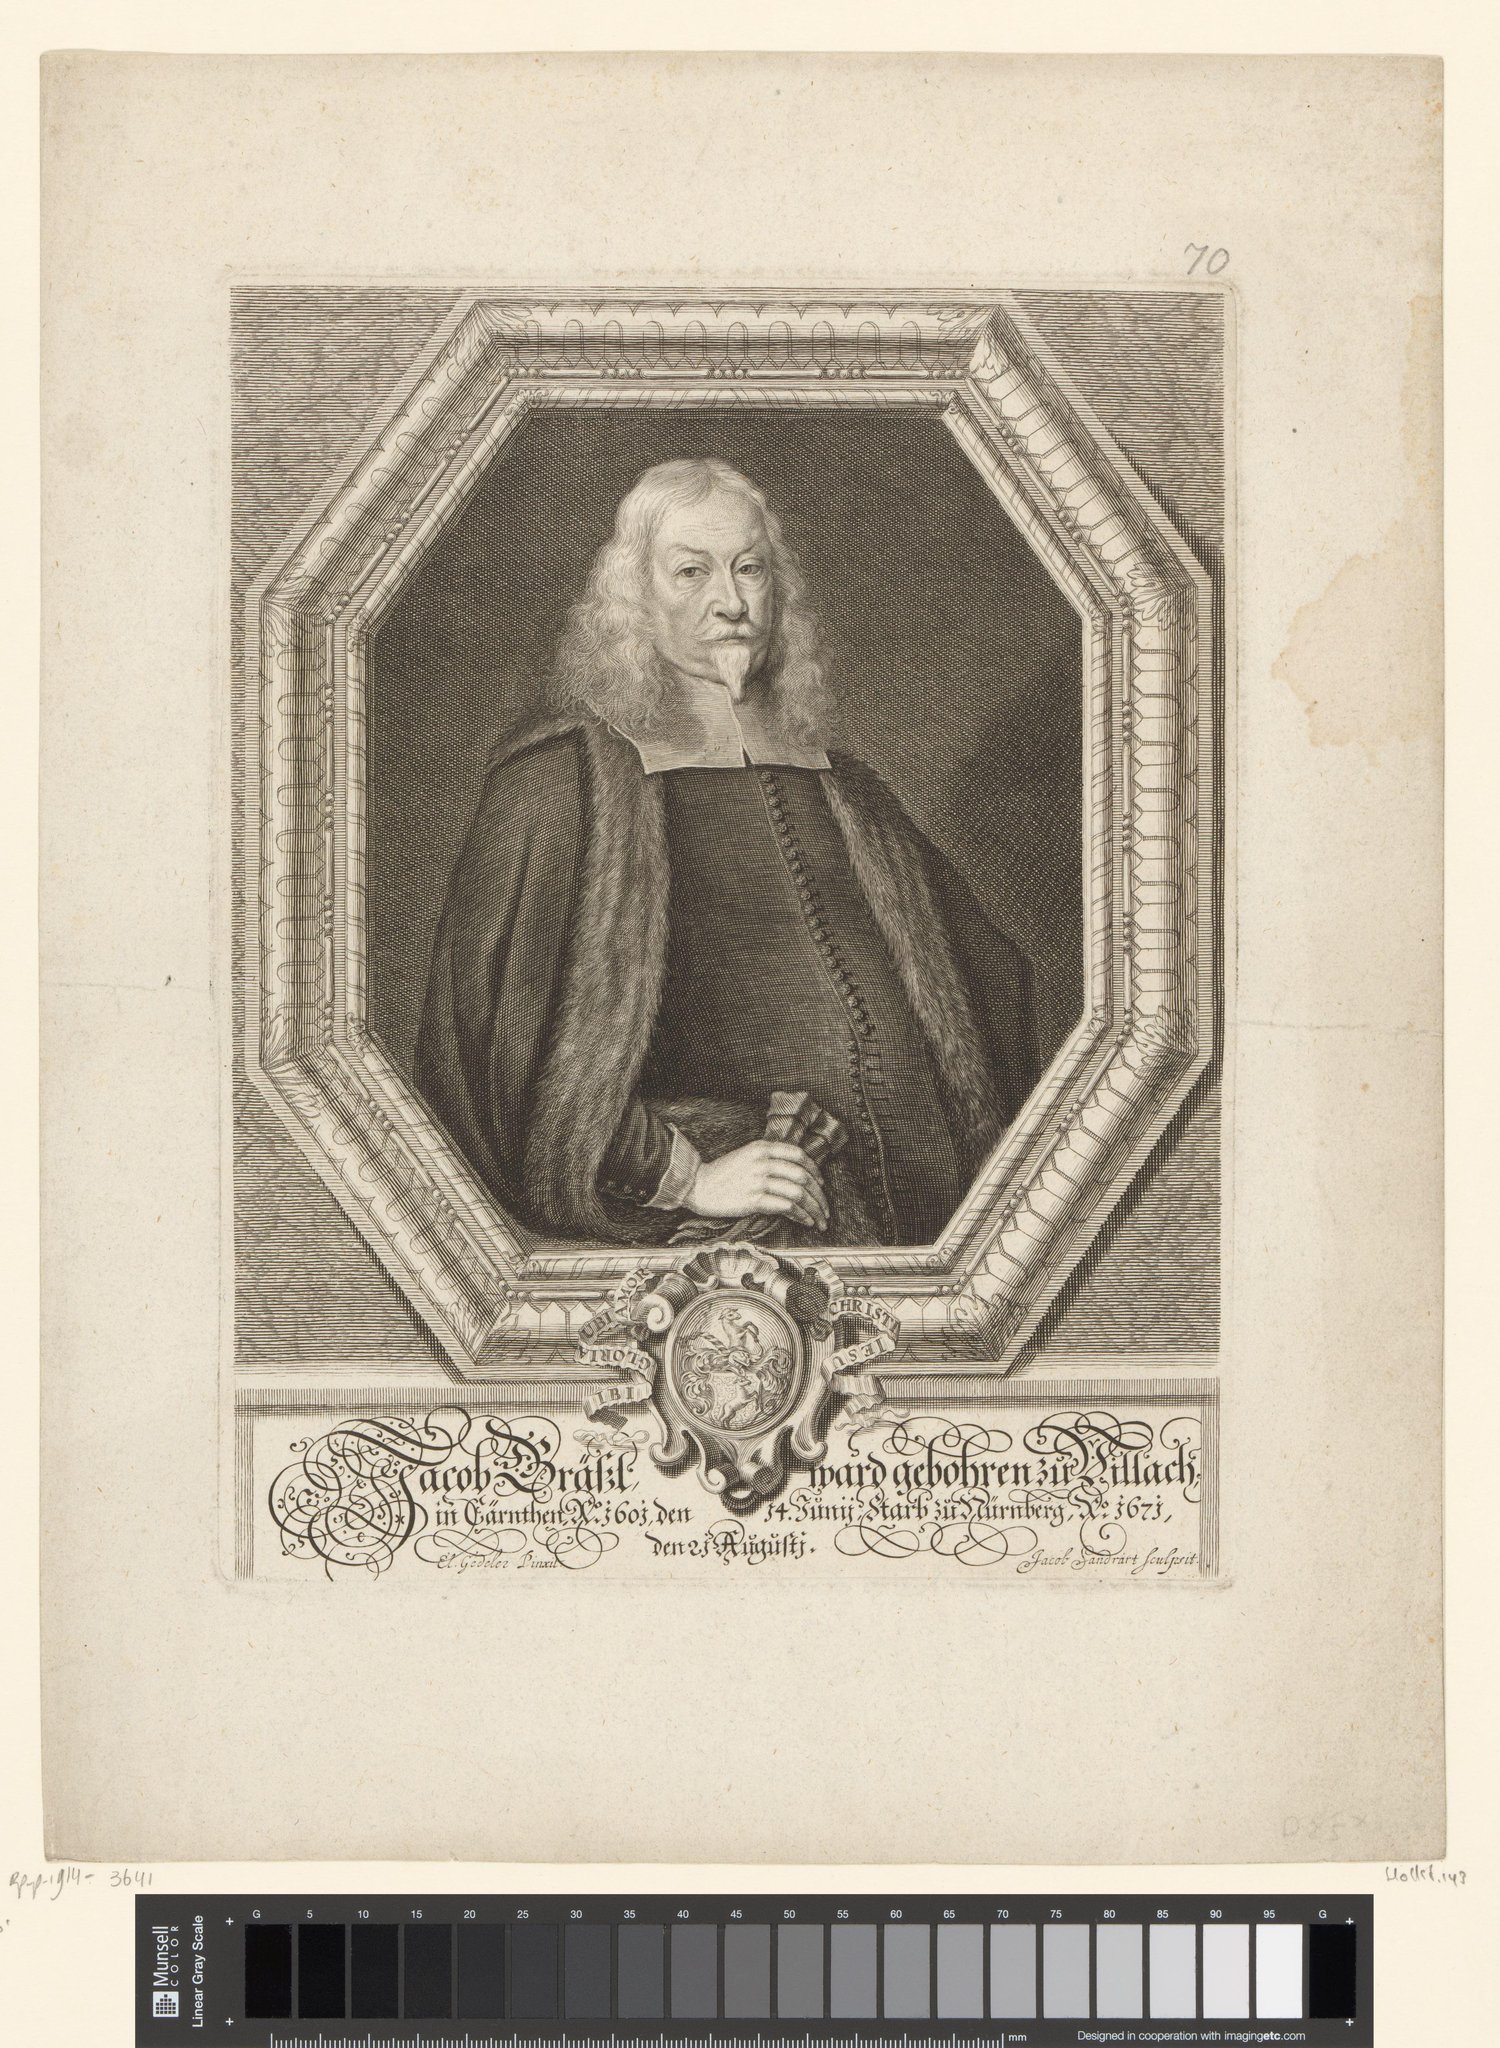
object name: print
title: Portret van Jacob Grässl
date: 1672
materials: paper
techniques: engraving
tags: historical persons, armorial bearing, heraldry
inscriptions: collector's mark: Lugt 2228